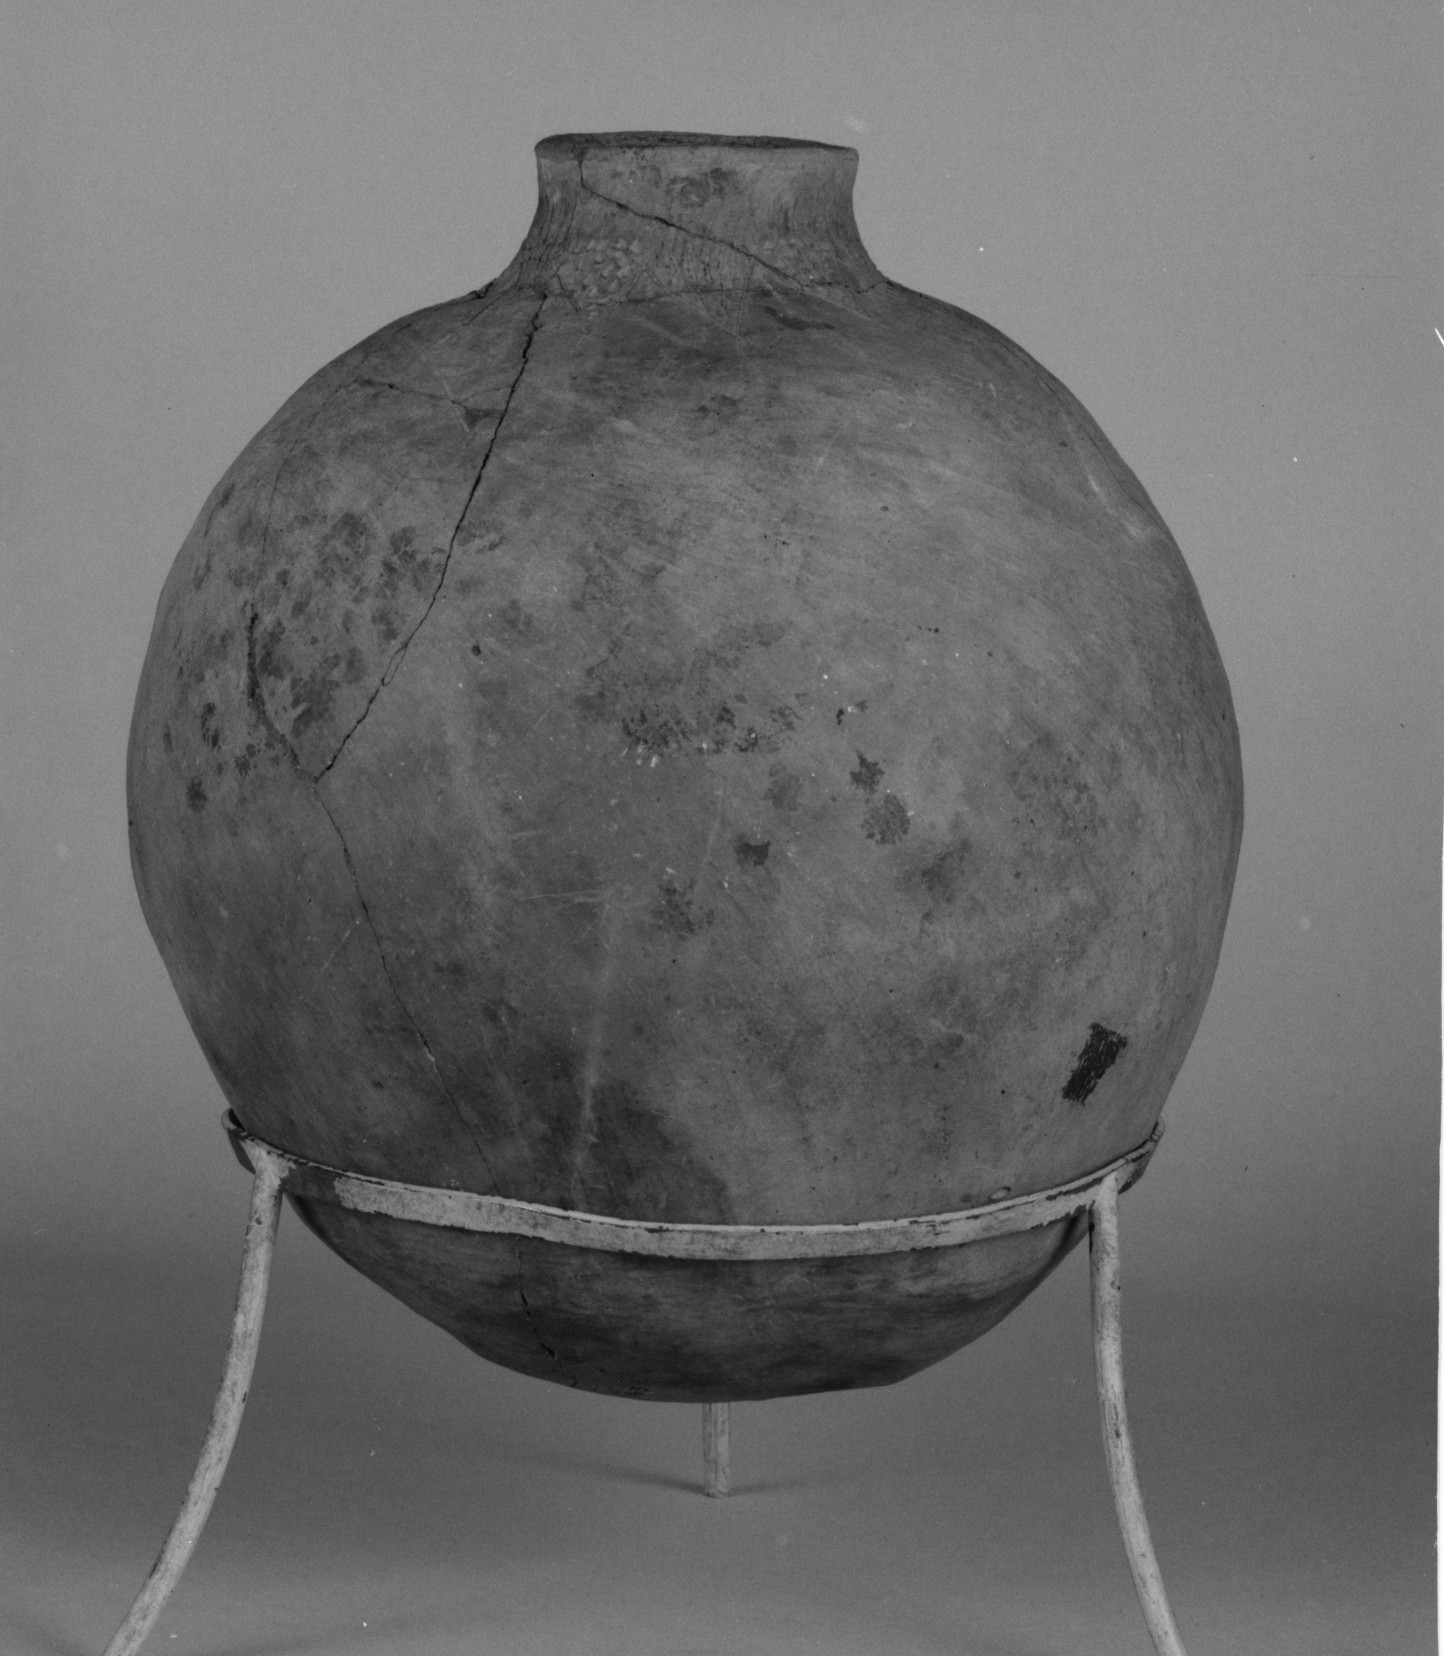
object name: jar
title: Storage jar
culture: paracas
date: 300-101 BCE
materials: ceramic, mica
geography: peru